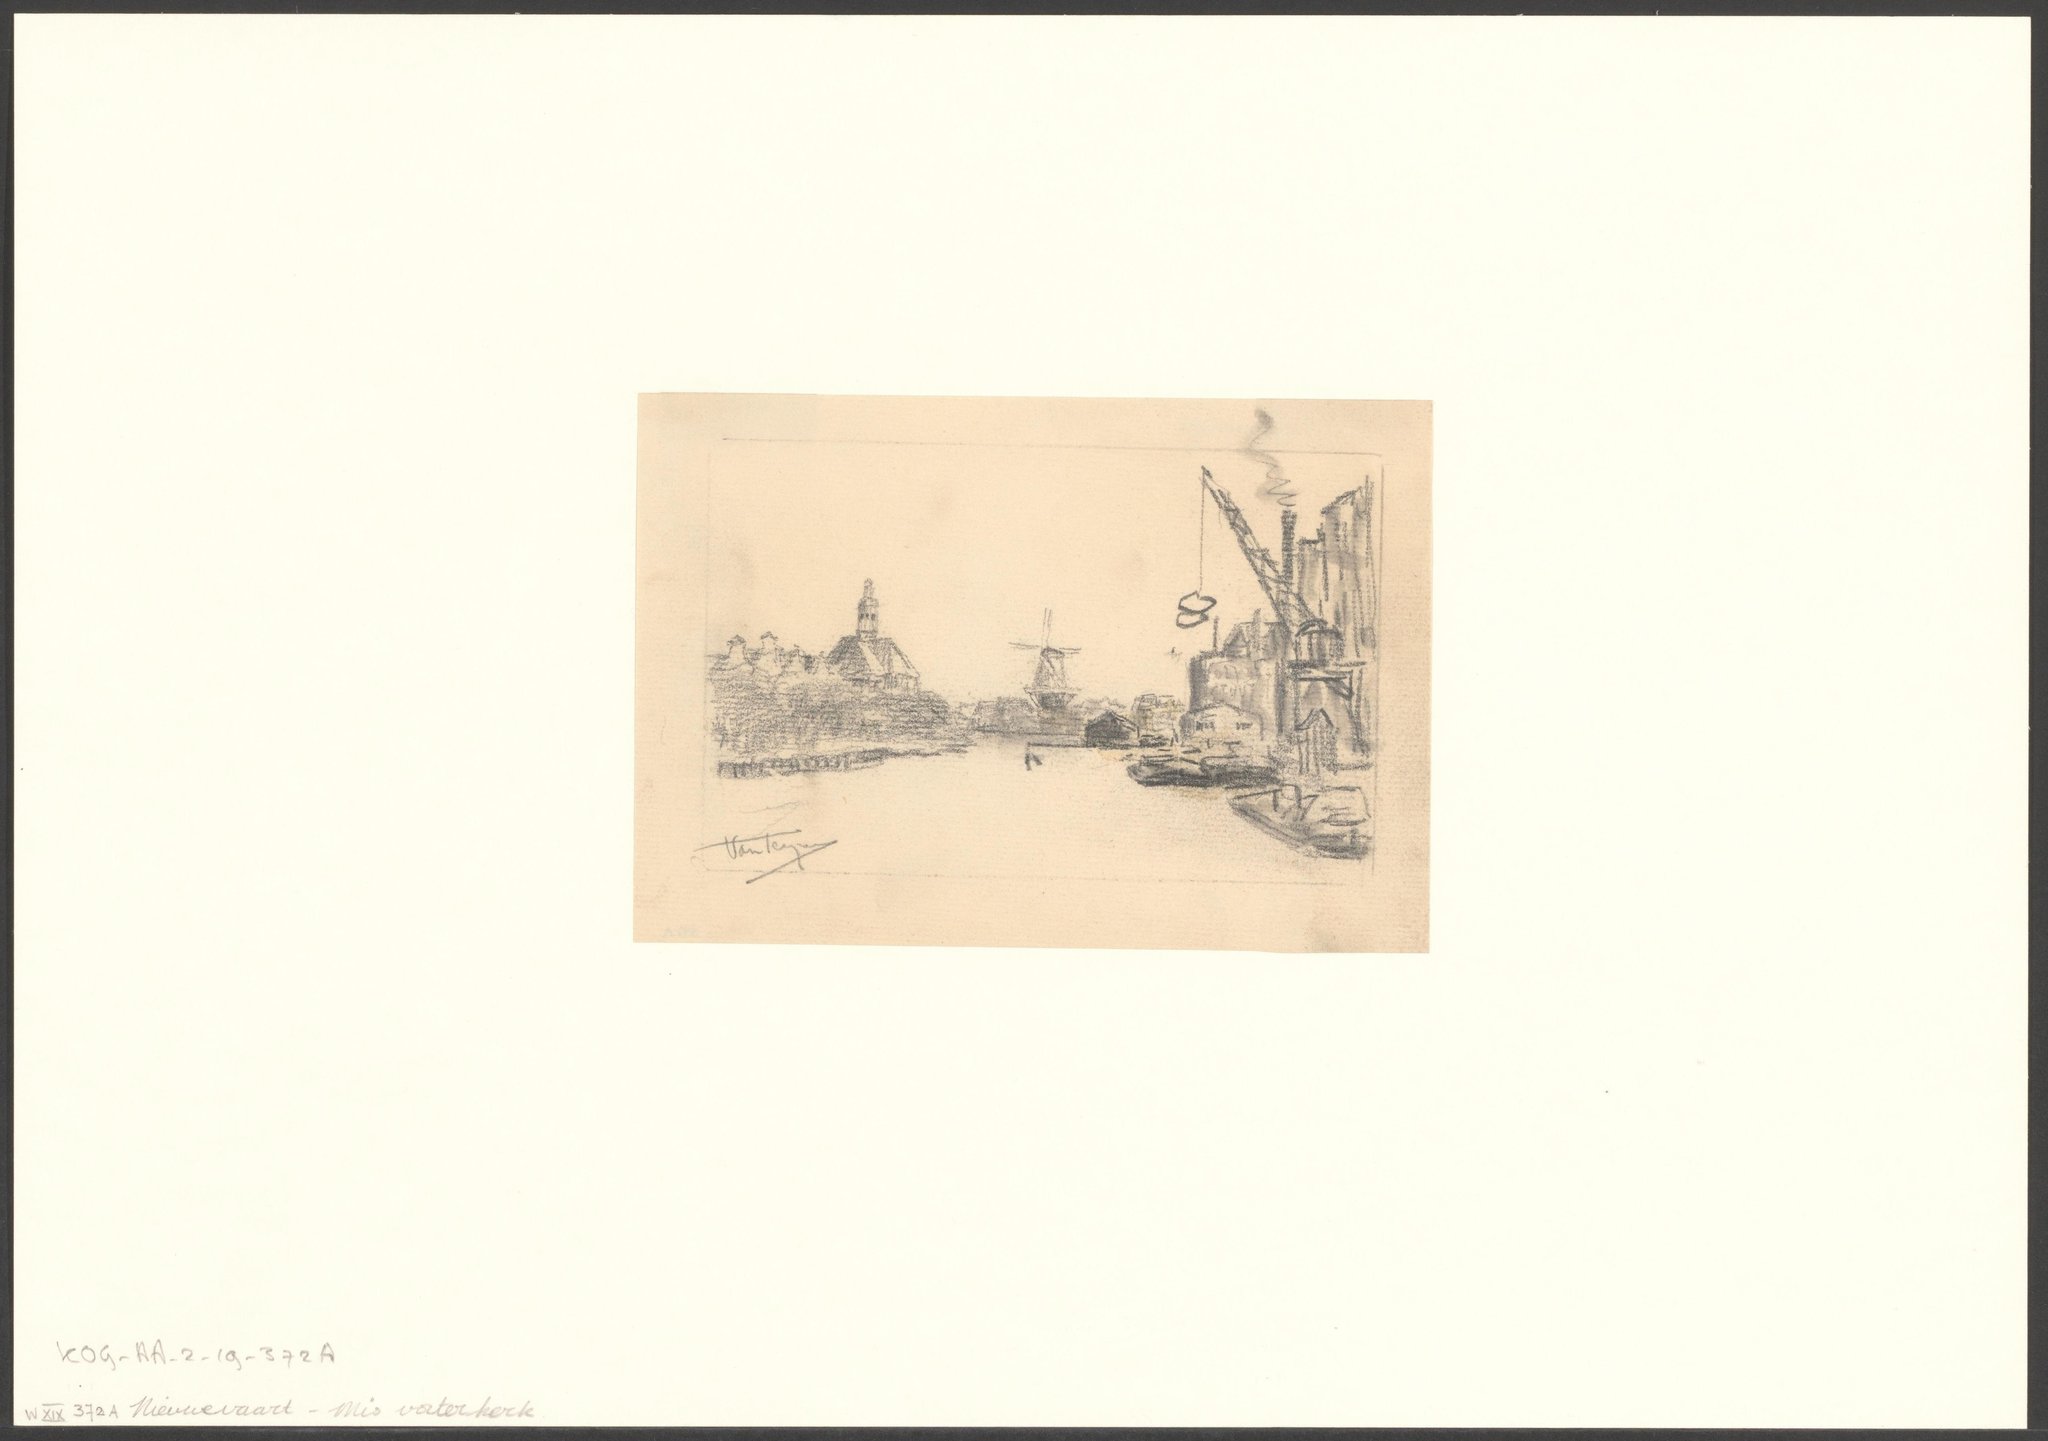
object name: drawing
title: Gezicht op de Nieuwe Vaart met de Oosterkerk en de molen De Gooyer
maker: anthonie van teijn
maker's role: draughtsman, painter, print maker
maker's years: 1863-1943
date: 1873-1943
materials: paper, pencil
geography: amsterdam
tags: city-view in general; 'veduta', canal, parts of church exterior and annexes, watermill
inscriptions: signature: ‘VanTeyne’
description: Tekening binnen de Atlas Van Eck ingedeeld op wijknummer 20.